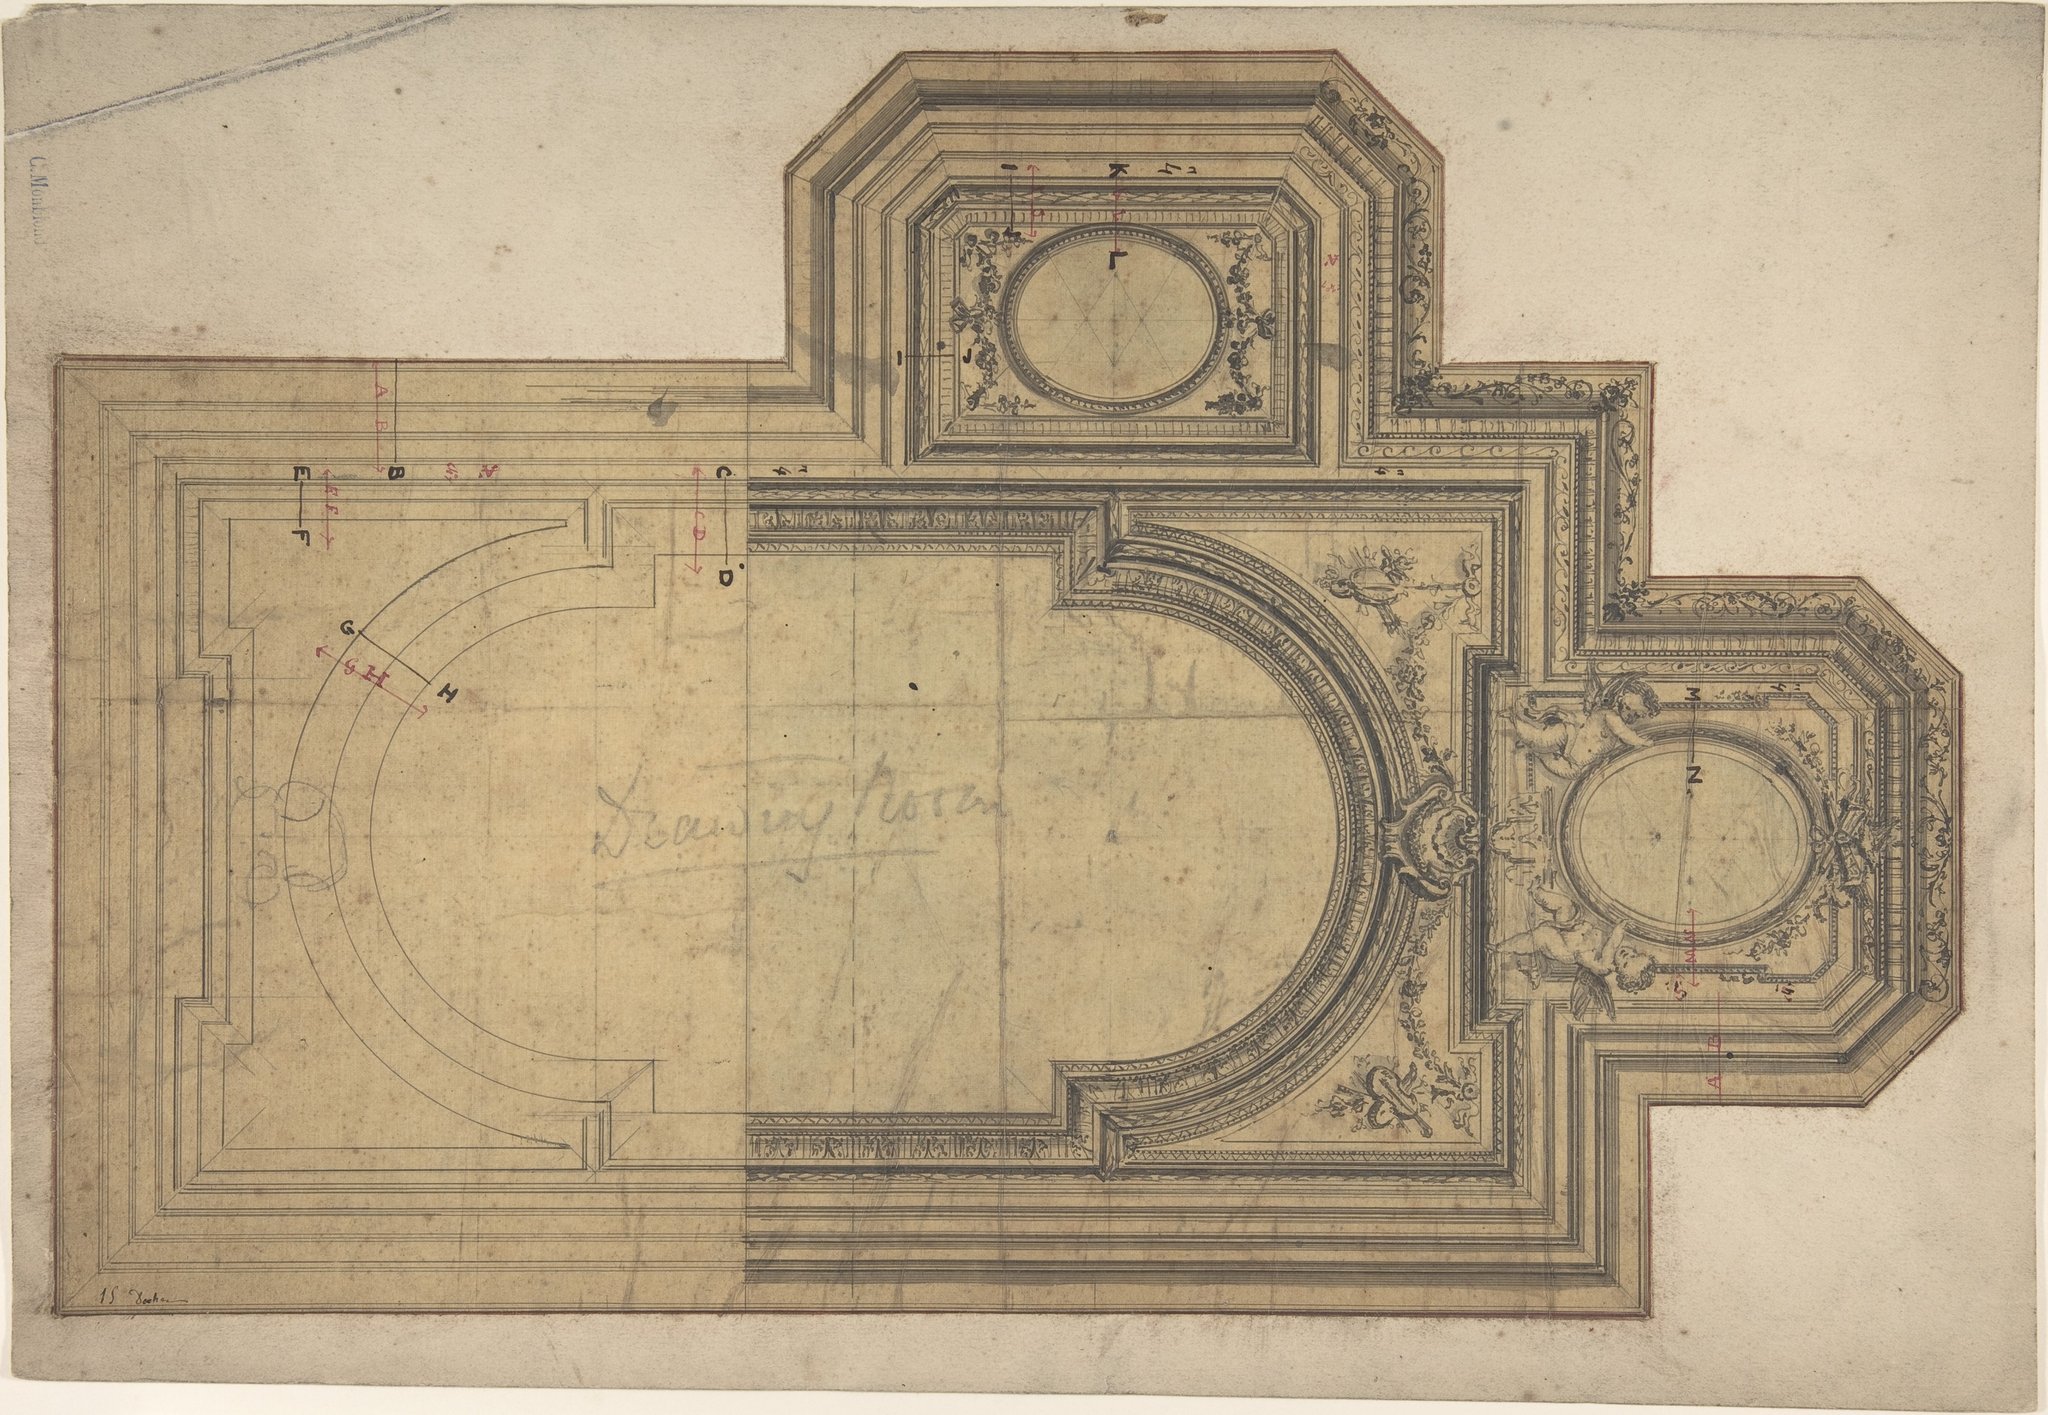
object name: drawing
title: Designs for Ceiling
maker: charles monblond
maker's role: artist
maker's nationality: french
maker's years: 1800-1900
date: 1801-1900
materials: ink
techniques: brush, pen, wash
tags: ceilings